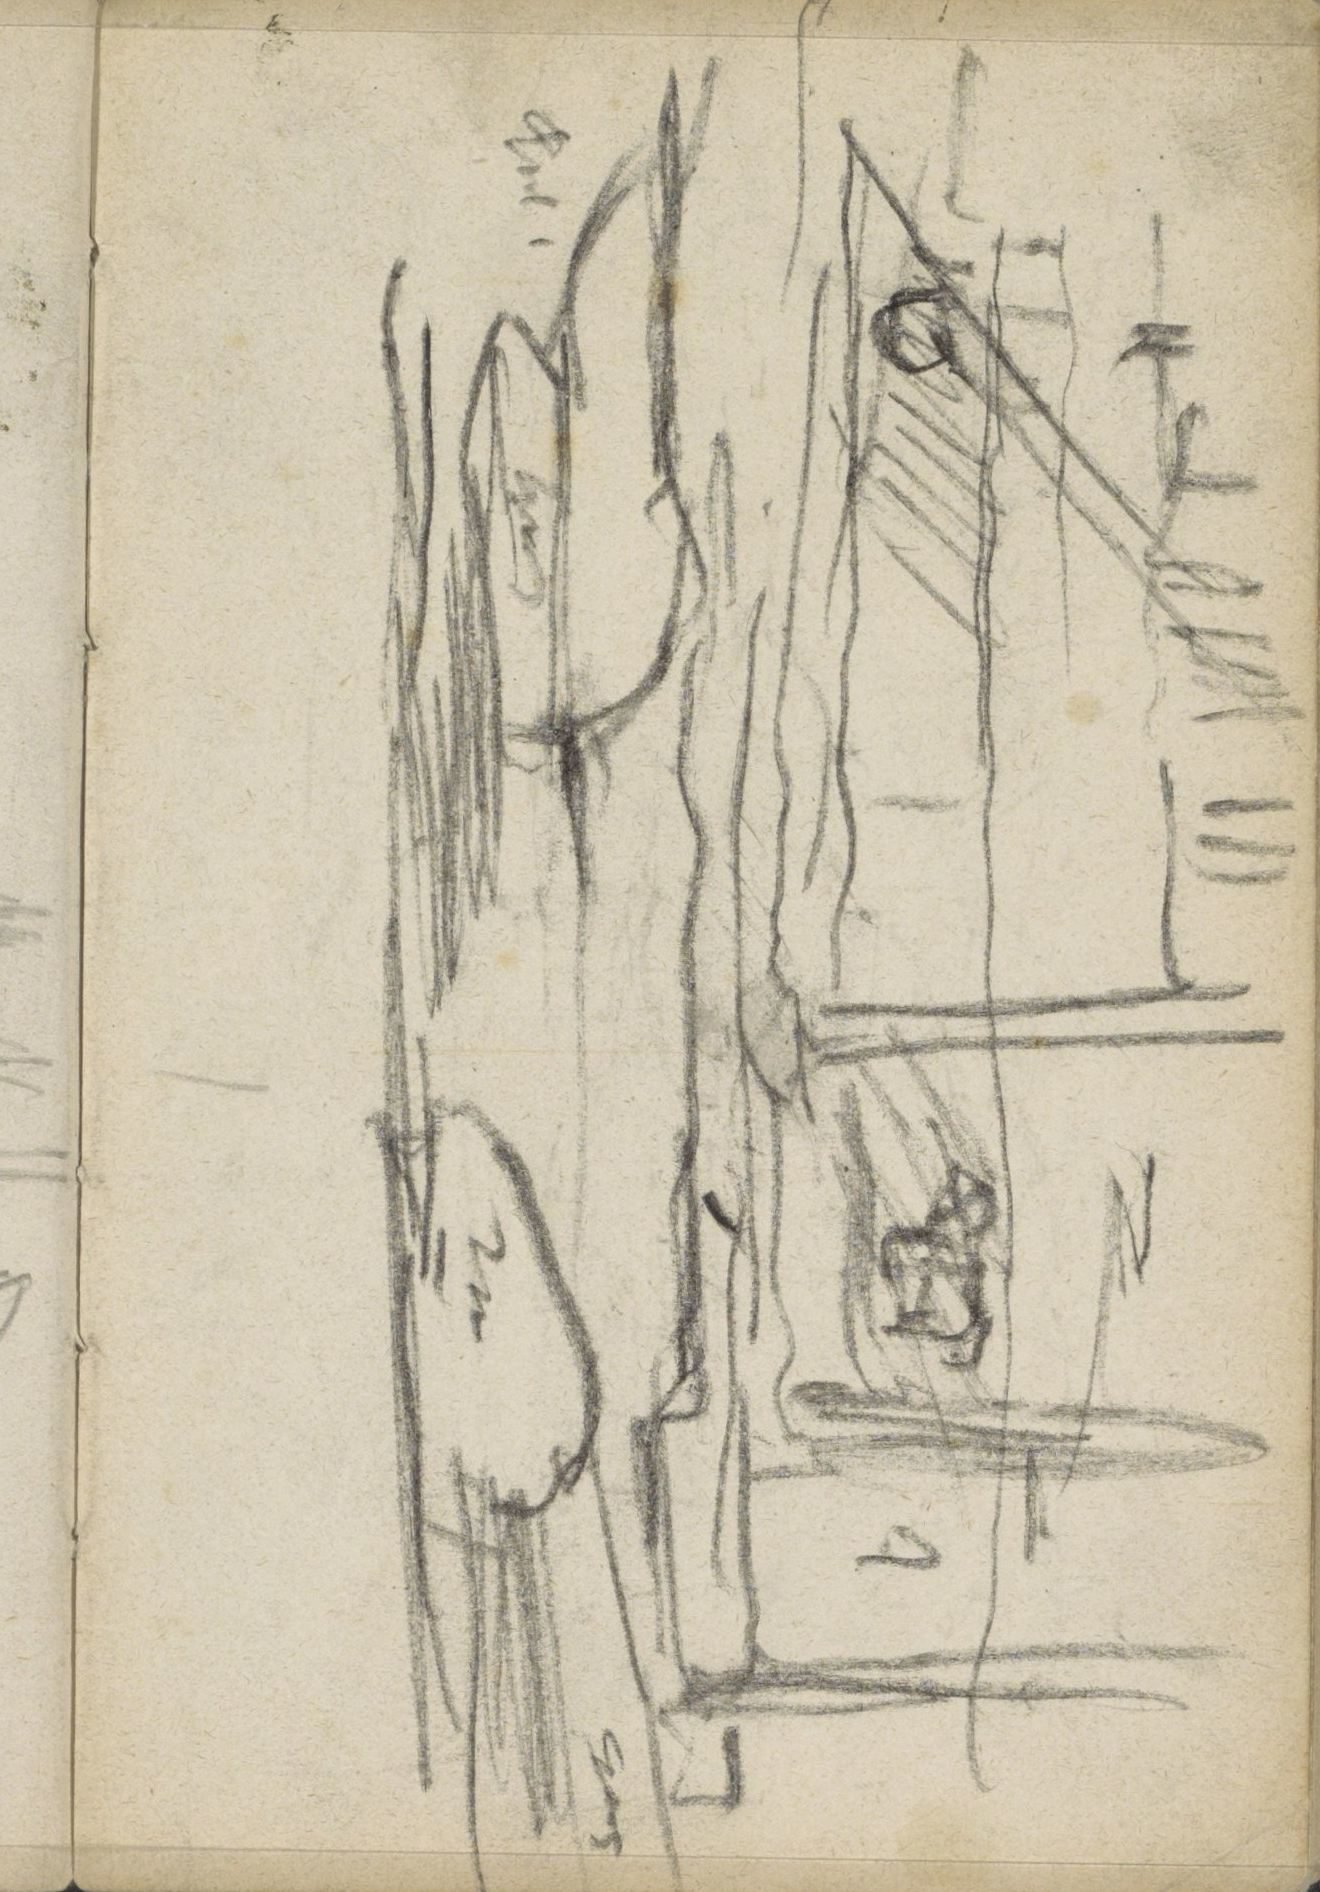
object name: sketchbook leaf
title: Aangemeerde schepen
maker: george hendrik breitner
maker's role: draughtsman, painter, print maker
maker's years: 1857-1923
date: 1900-1901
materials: chalk, paper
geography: amsterdam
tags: ships (in general)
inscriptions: kleurnotitie, handgeschreven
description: Aangemeerde schepen. Pagina 52 uit een schetsboek met 46 bladen vervaardigd te Amsterdam.